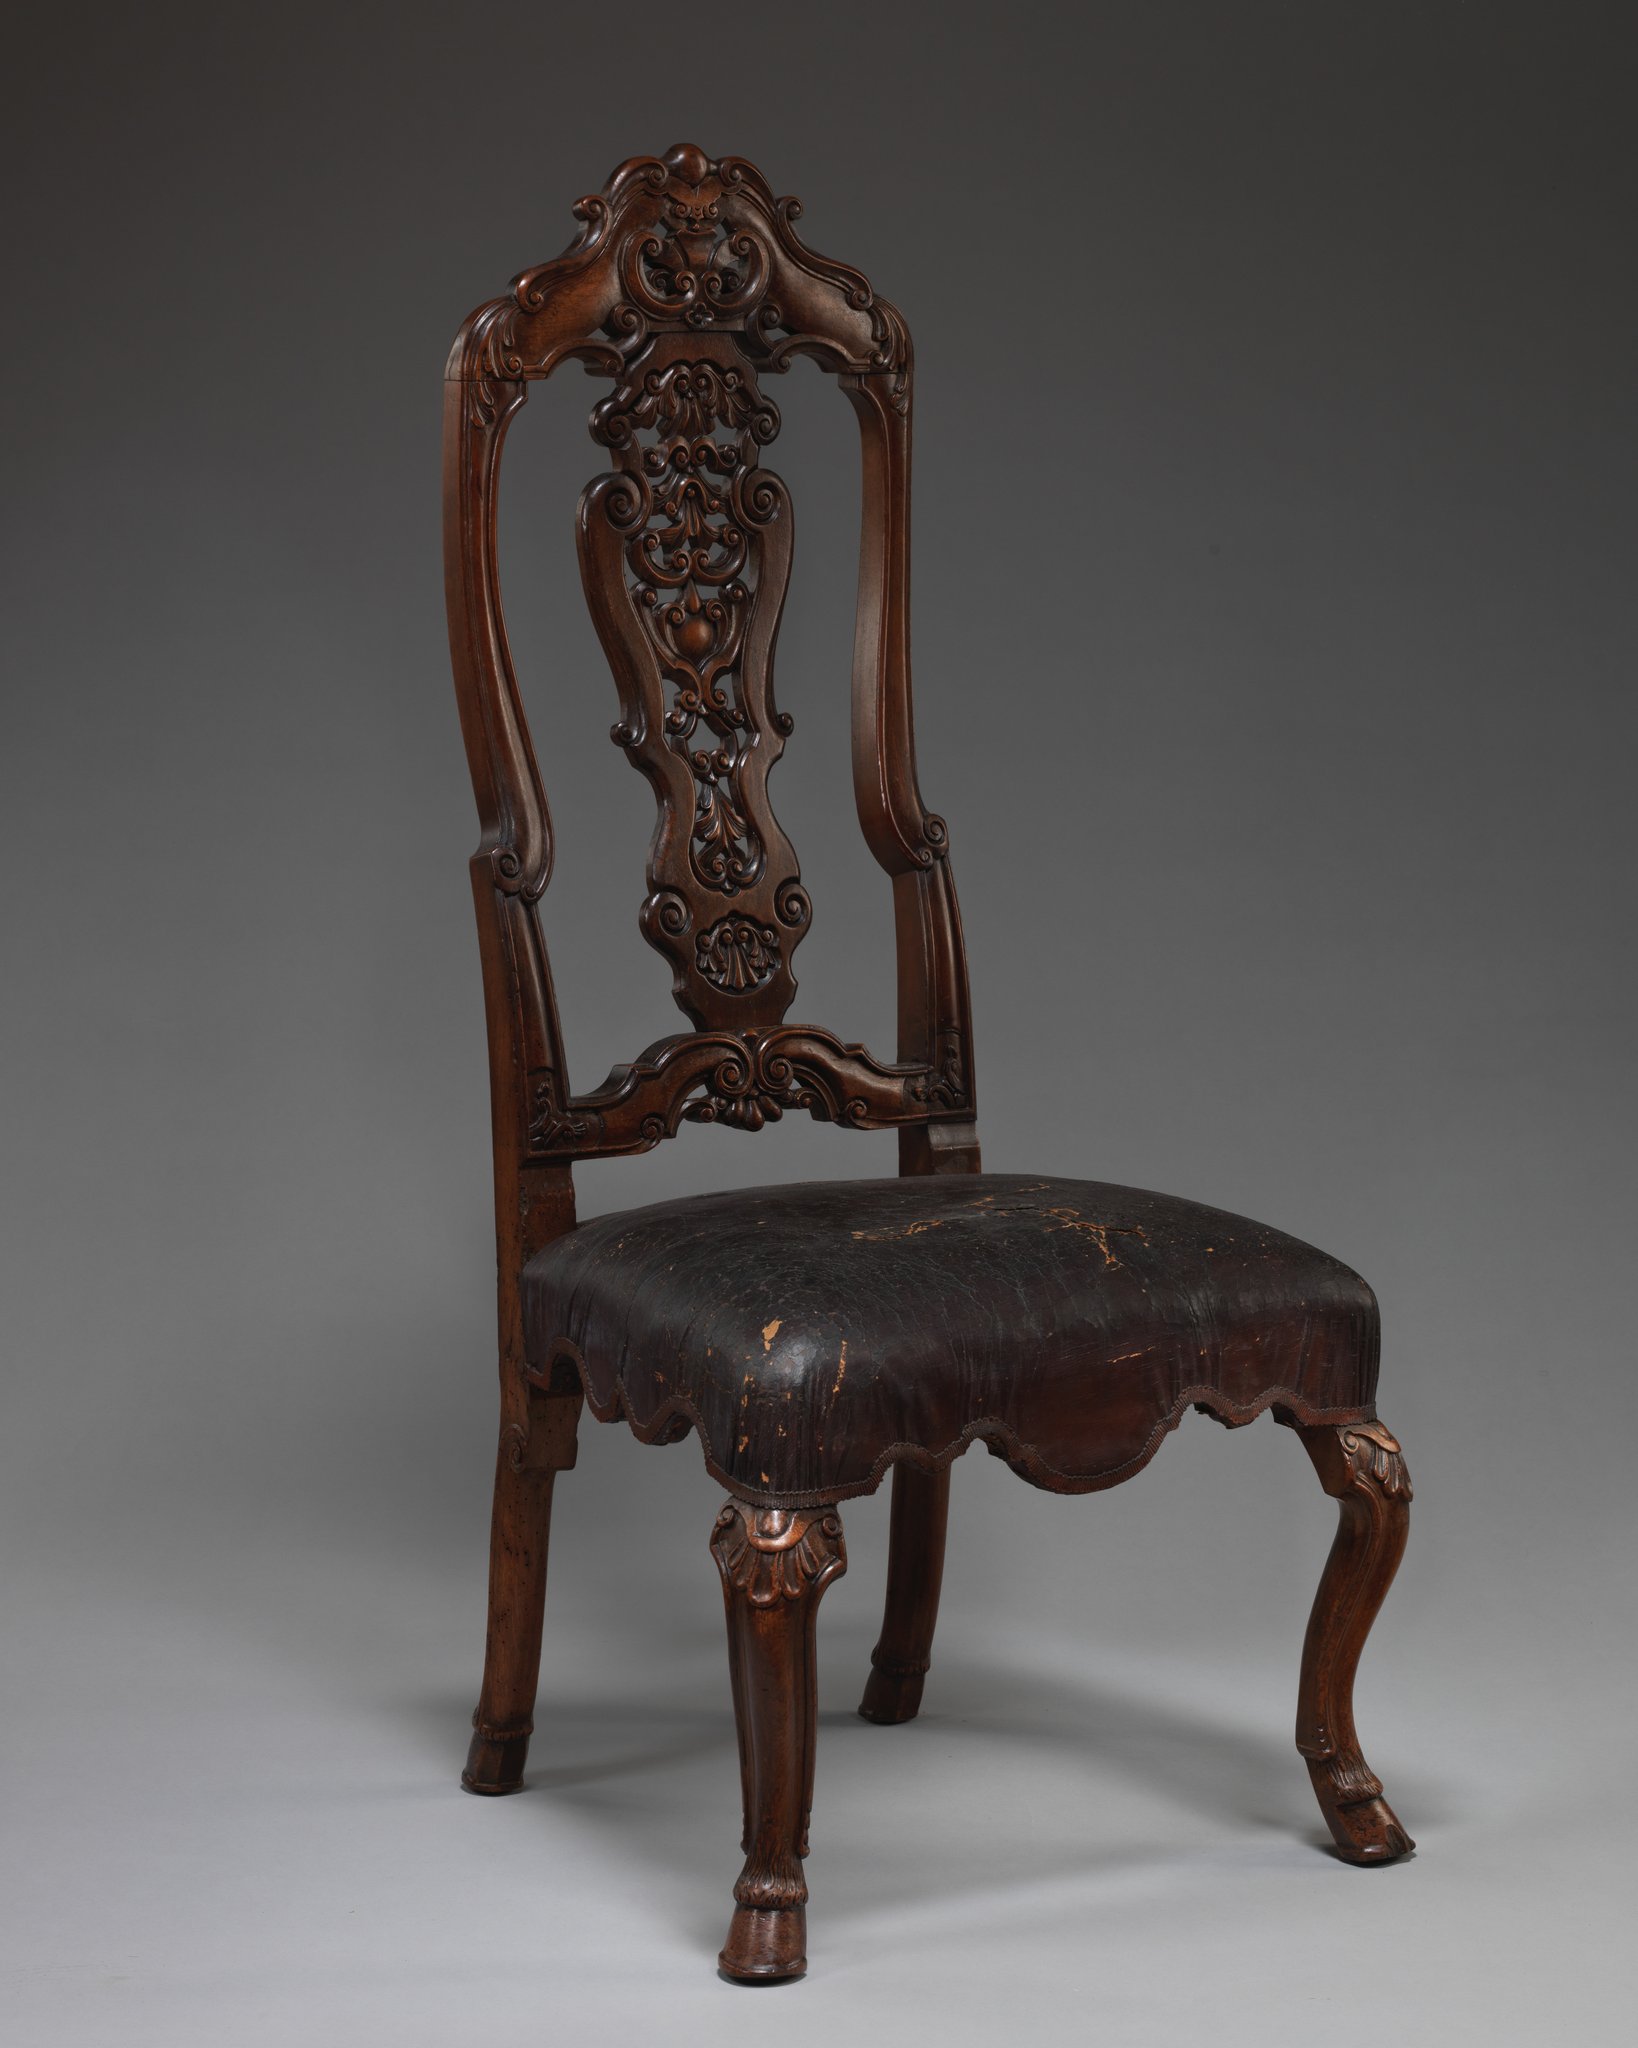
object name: chair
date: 1710-1720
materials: wood